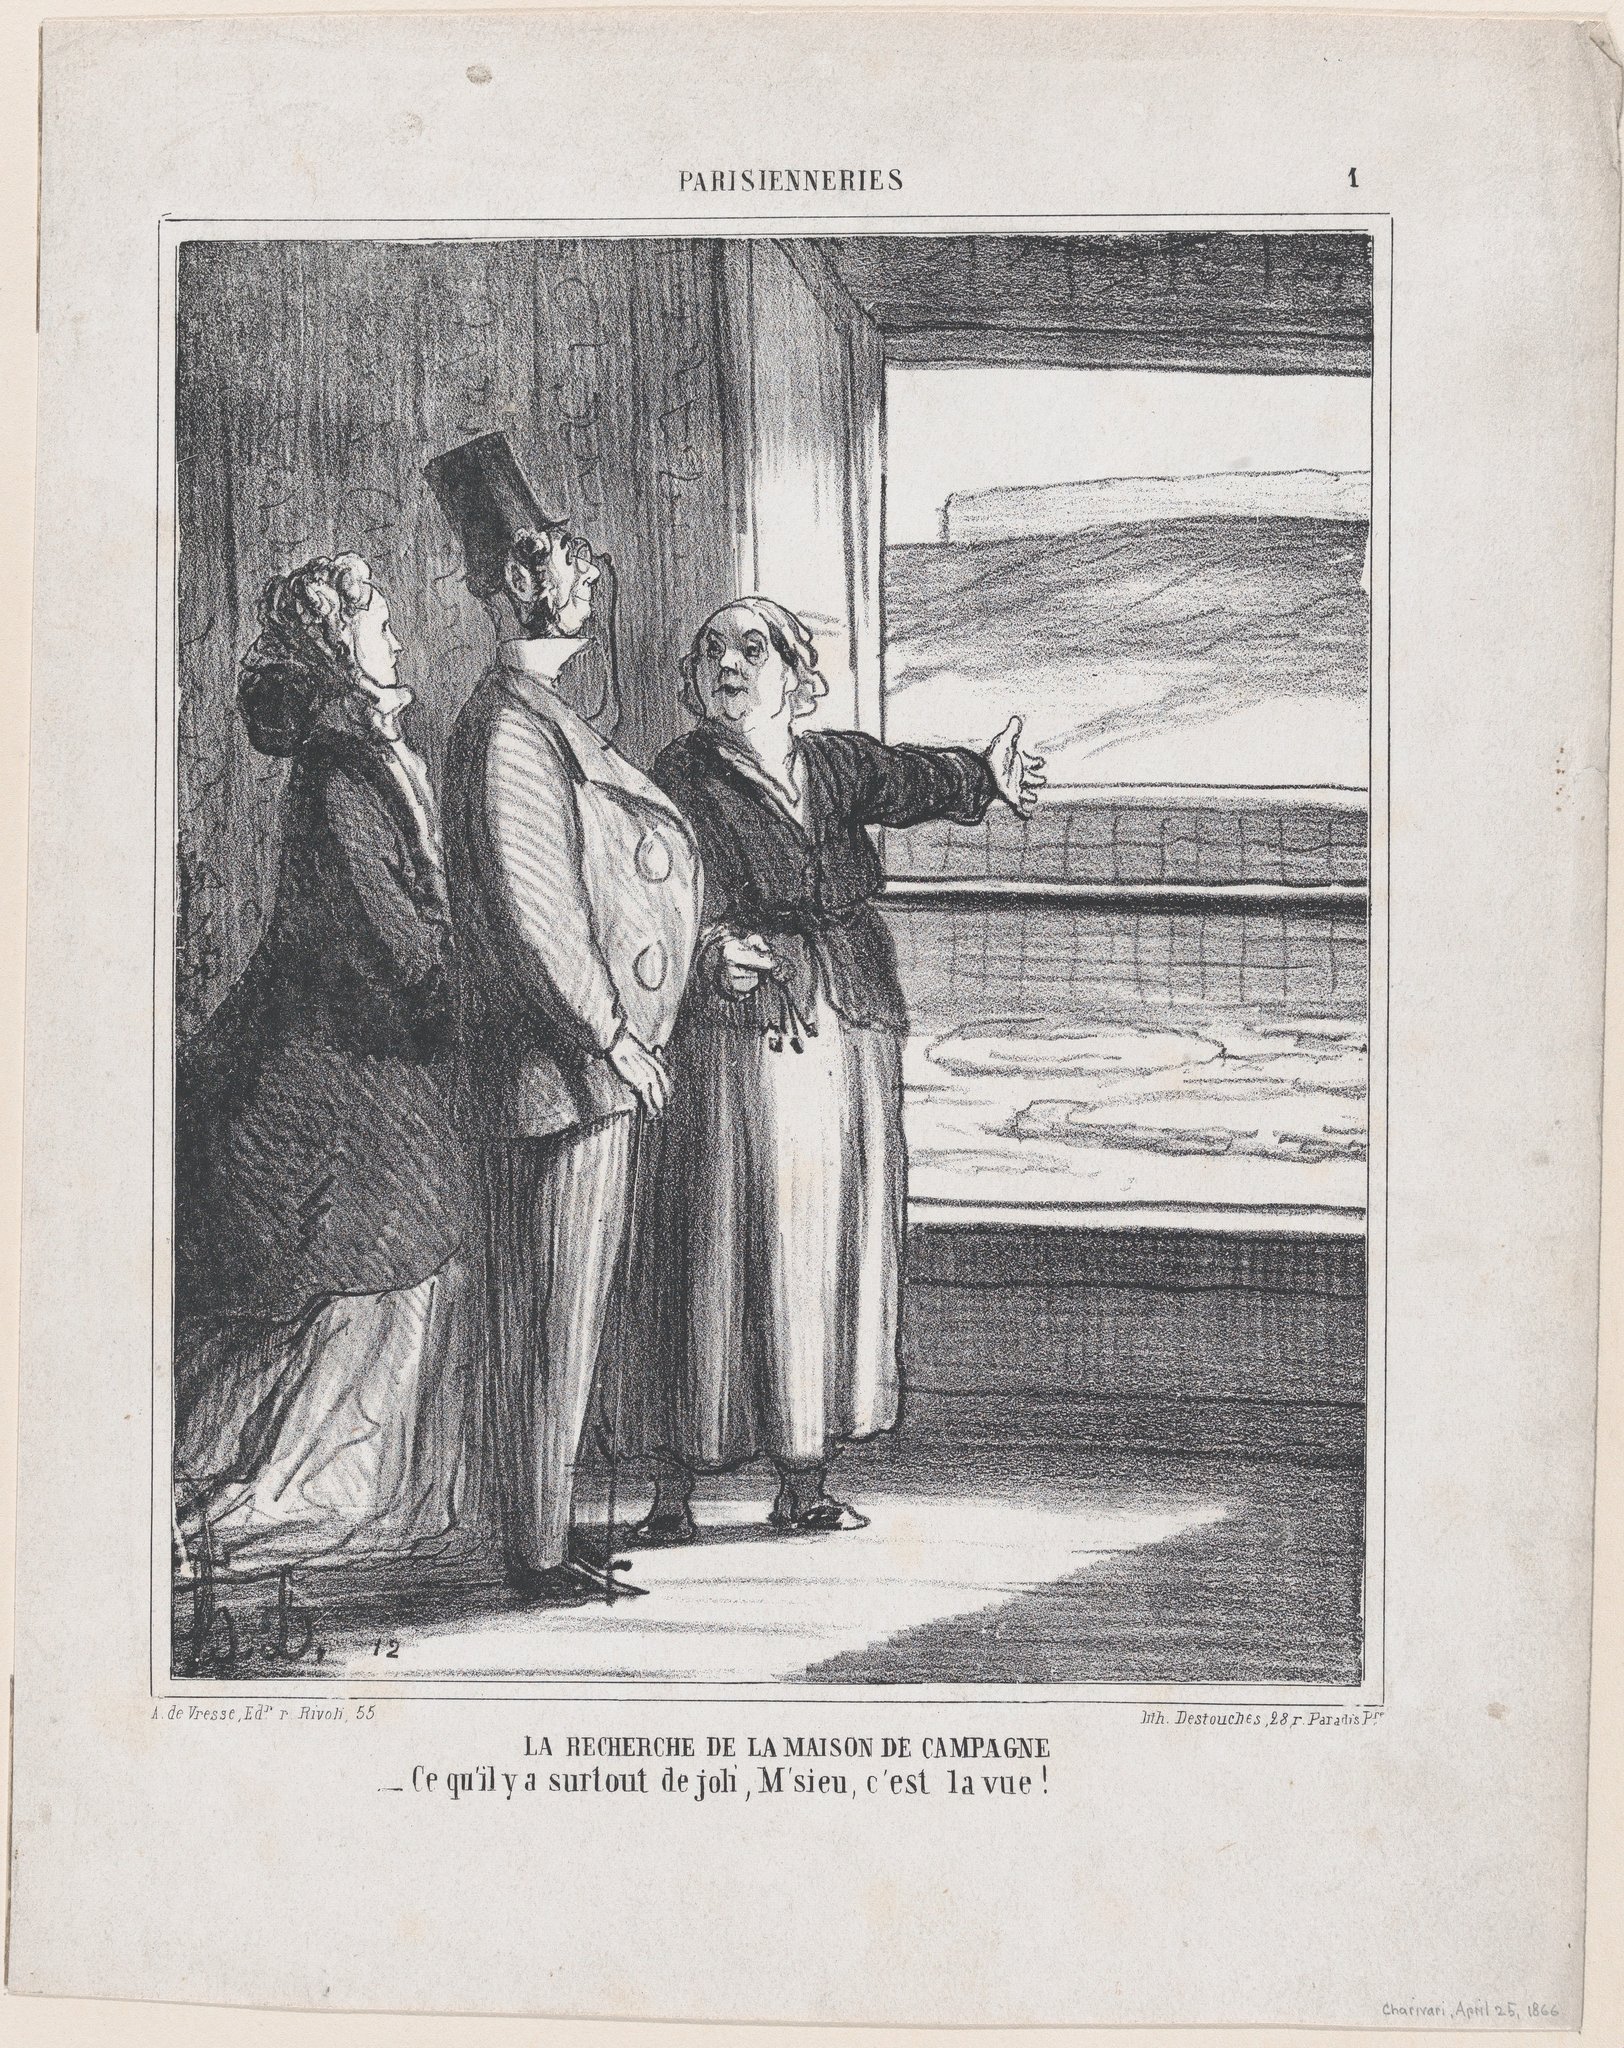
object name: print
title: The search for a house in the country: What is especially beautiful, sir, is the view!, from 'Parisian habits,' published in Le Charivari, April 25, 1866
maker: honoré daumier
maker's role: artist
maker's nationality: french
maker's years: 1808-1879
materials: paper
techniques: lithograph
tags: satire,men,women